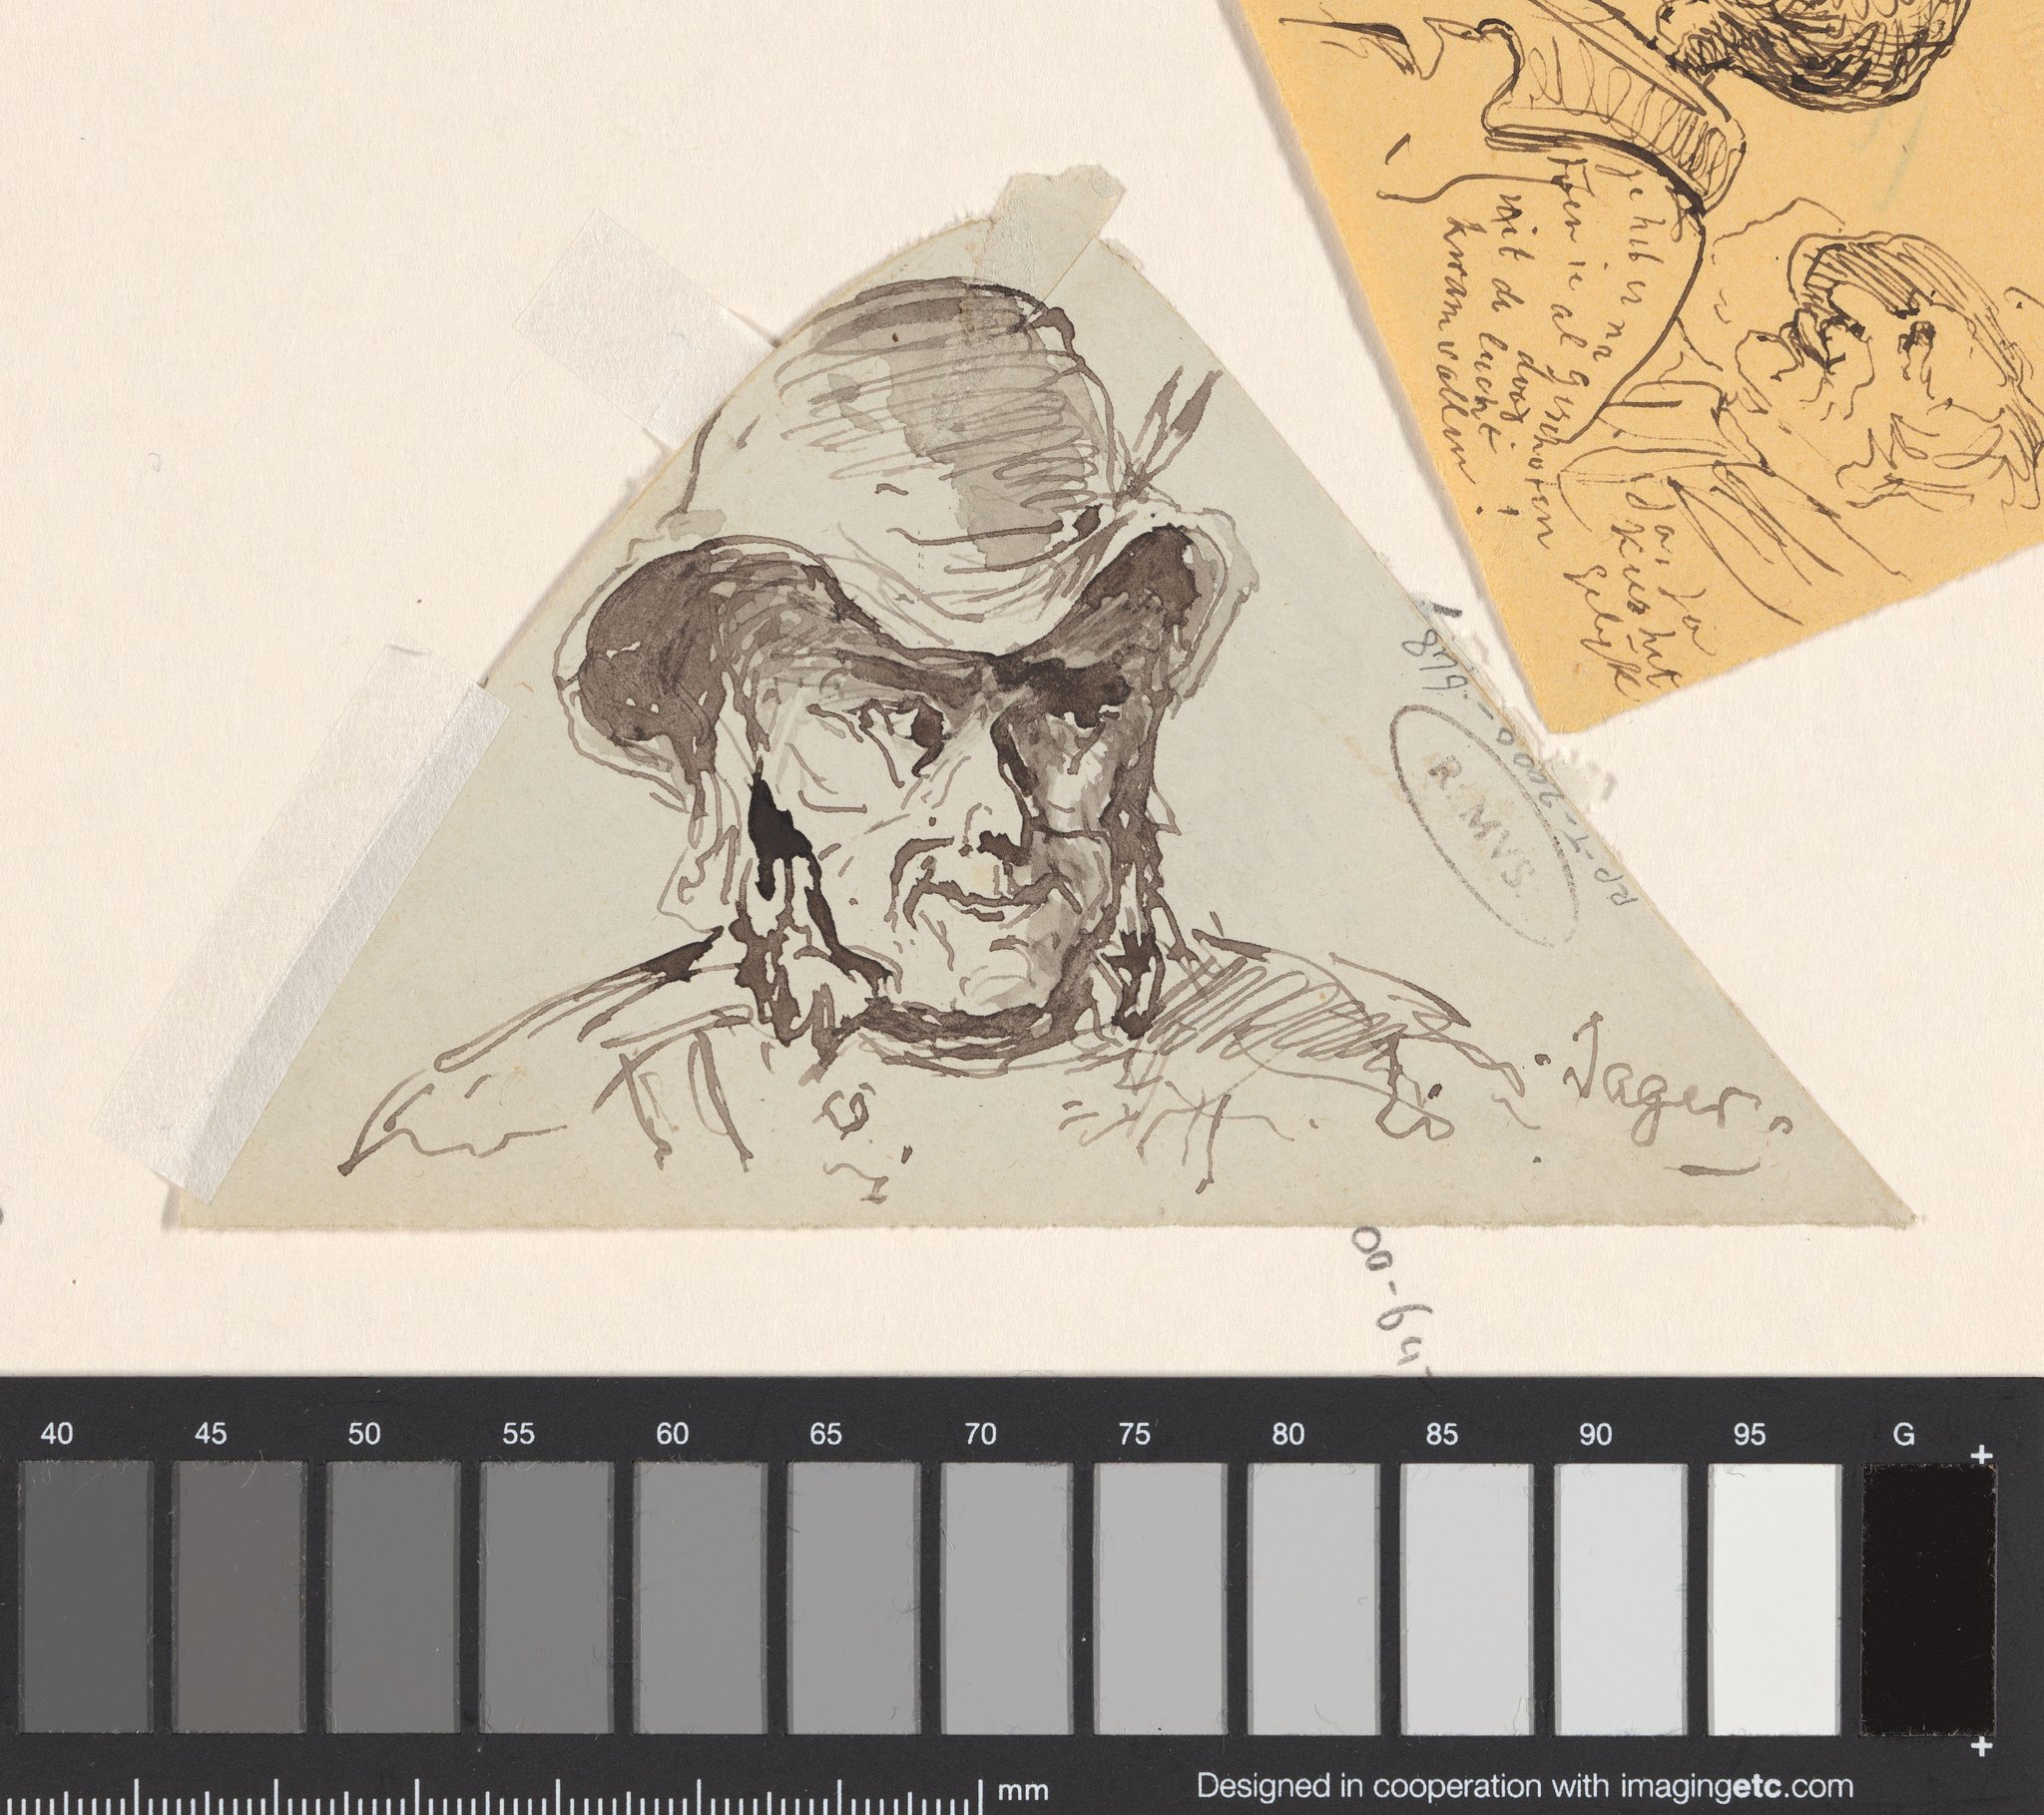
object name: drawing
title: Jager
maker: johannes tavenraat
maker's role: draughtsman, painter, print maker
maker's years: 1809-1881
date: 1843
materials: ink, paper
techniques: brush, pen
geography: materborn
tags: hunter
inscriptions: date and inscription: ‘Materborn drijver - 1843’, annotation: ‘"jager"’, collector's mark: Lugt 2228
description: Kop van een jager. Getekend op een fragment van een envelop.